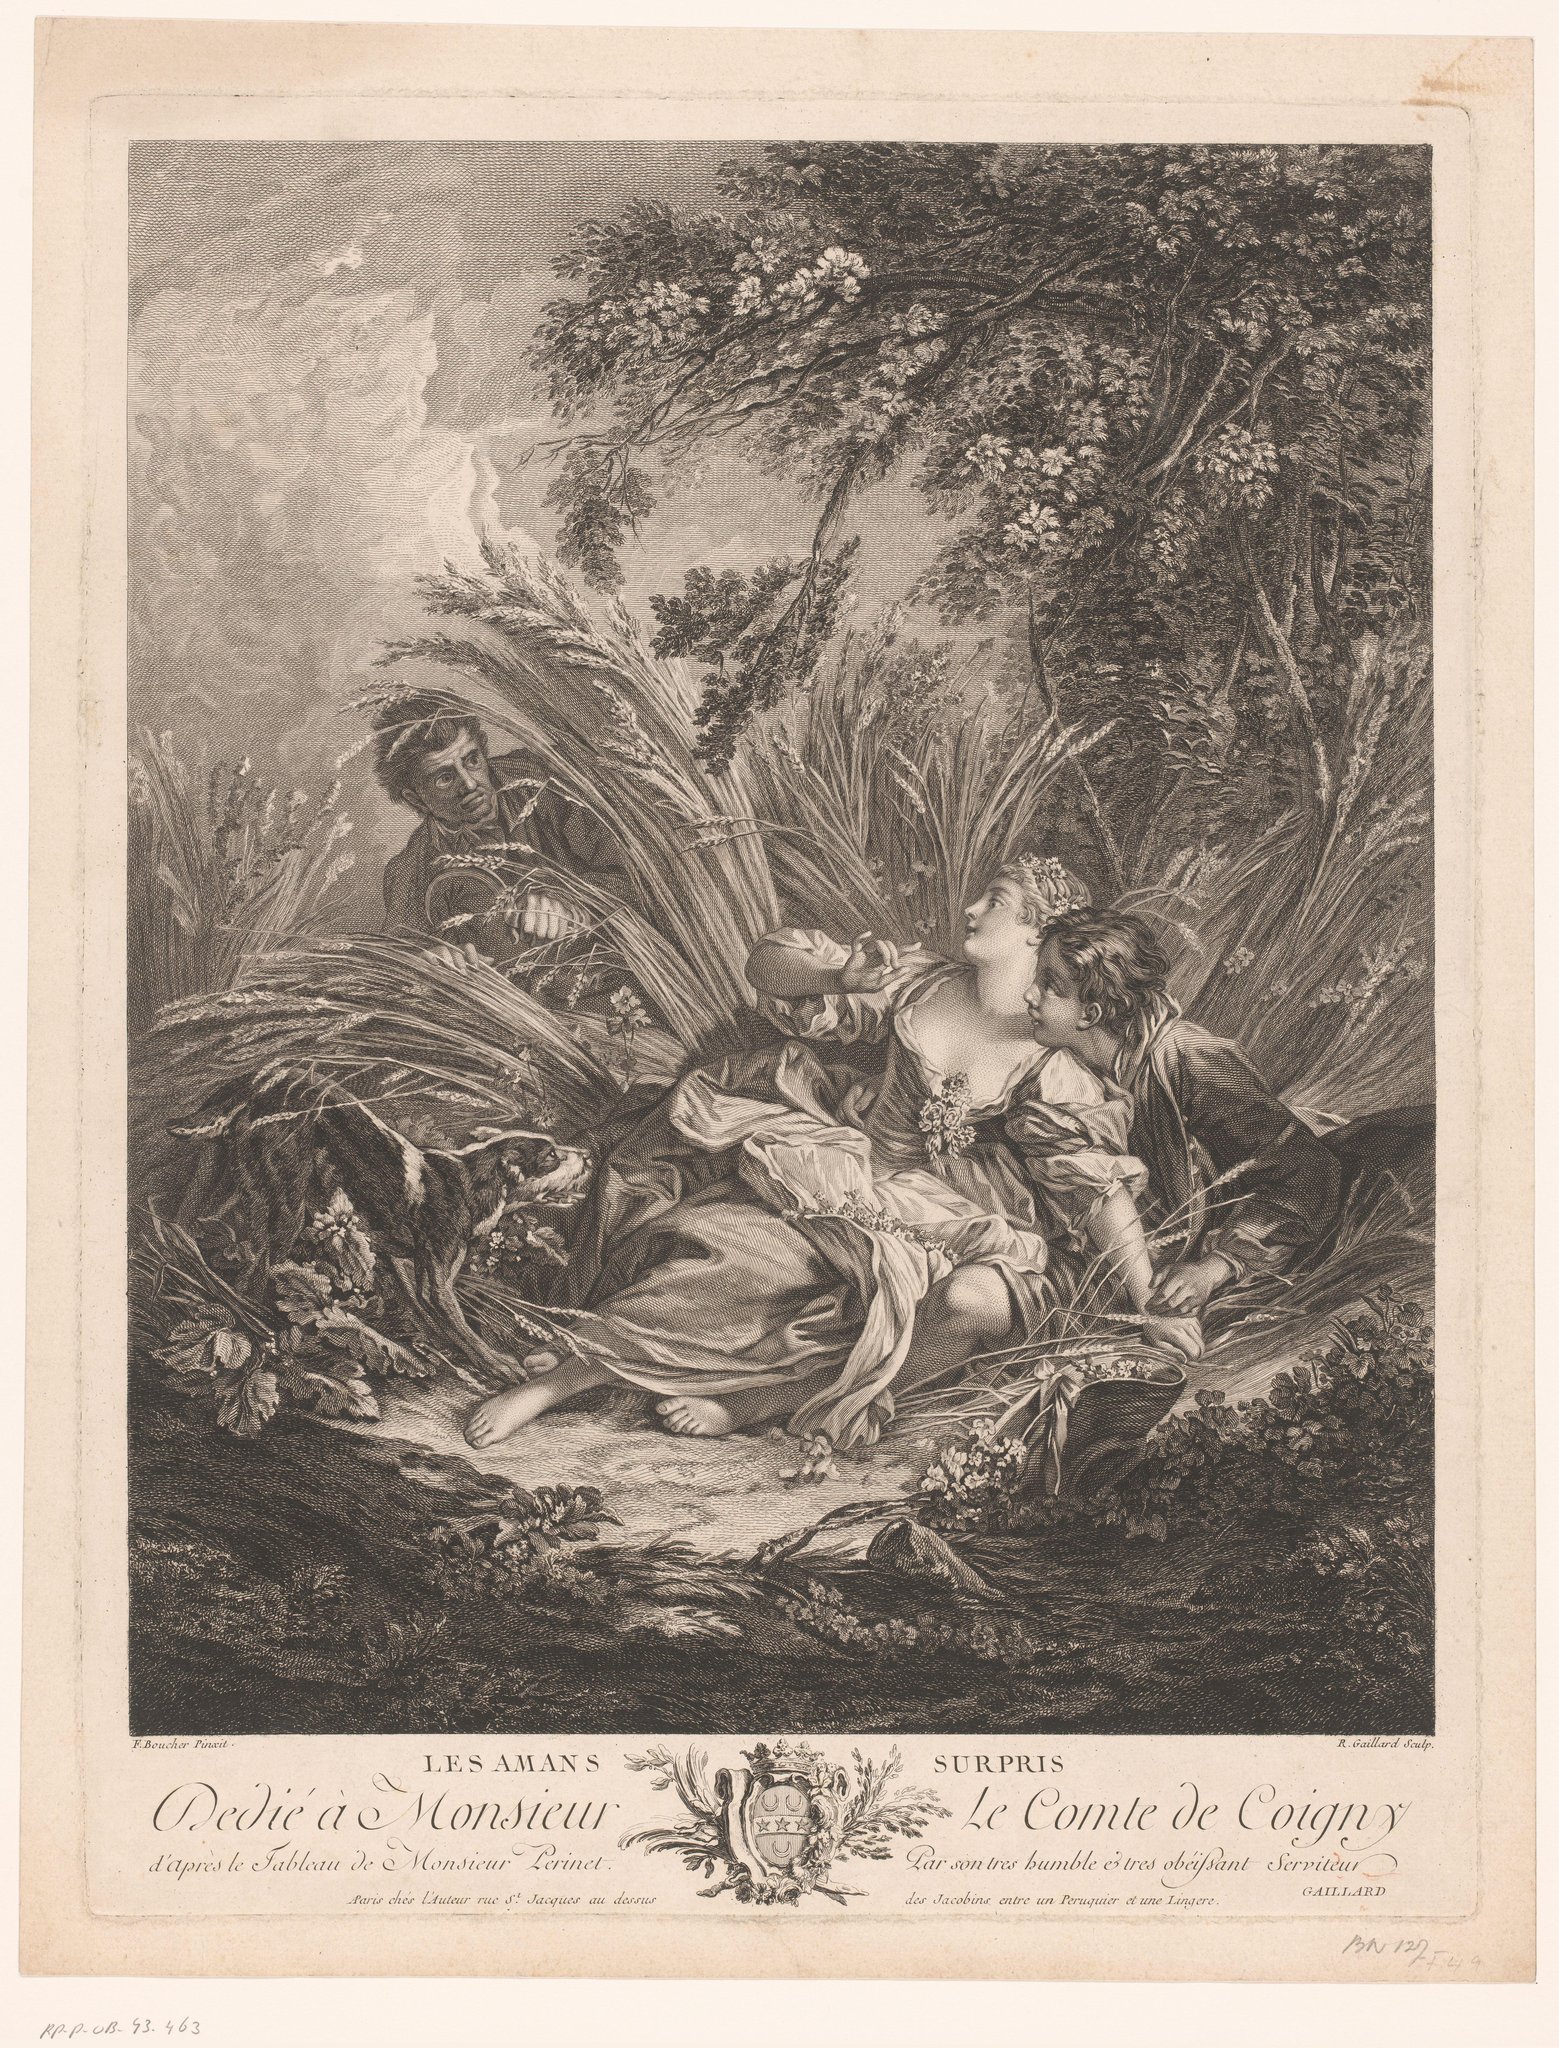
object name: print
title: Geliefden betrapt tussen het riet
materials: paper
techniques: engraving, etching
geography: paris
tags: herding, herdsman, herdswoman, shepherd, shepherdess, cowherd, etc., (lovers) embracing each other, 'symplegma', interrupted meeting, lovers caught by surprise